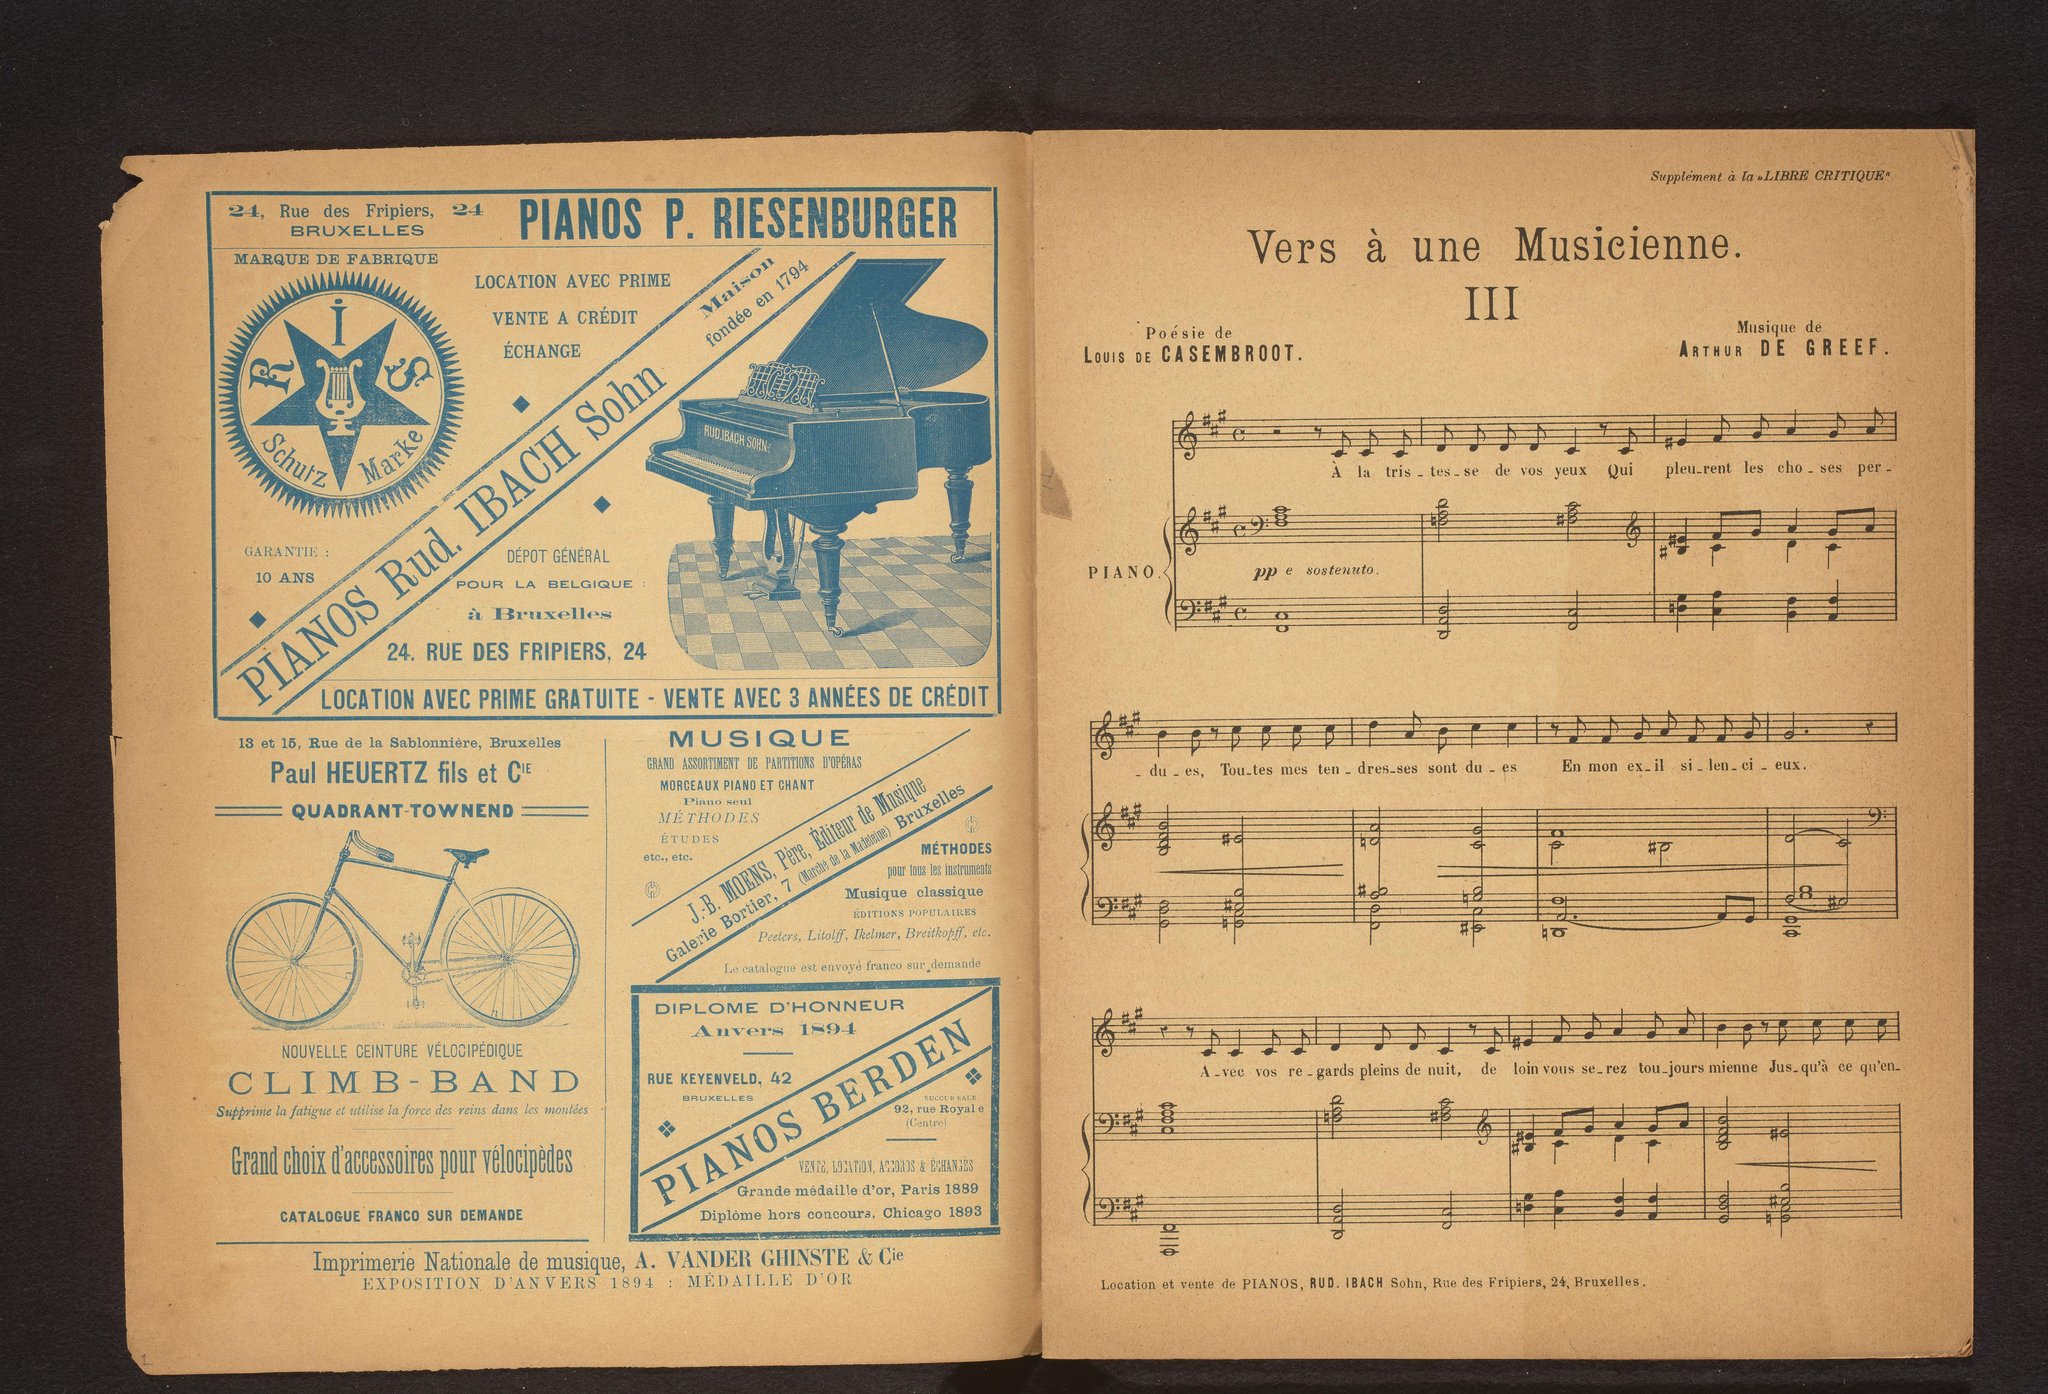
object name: book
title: La libre critique revue d'art et de littérature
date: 1895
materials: paper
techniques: photograph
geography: brussels